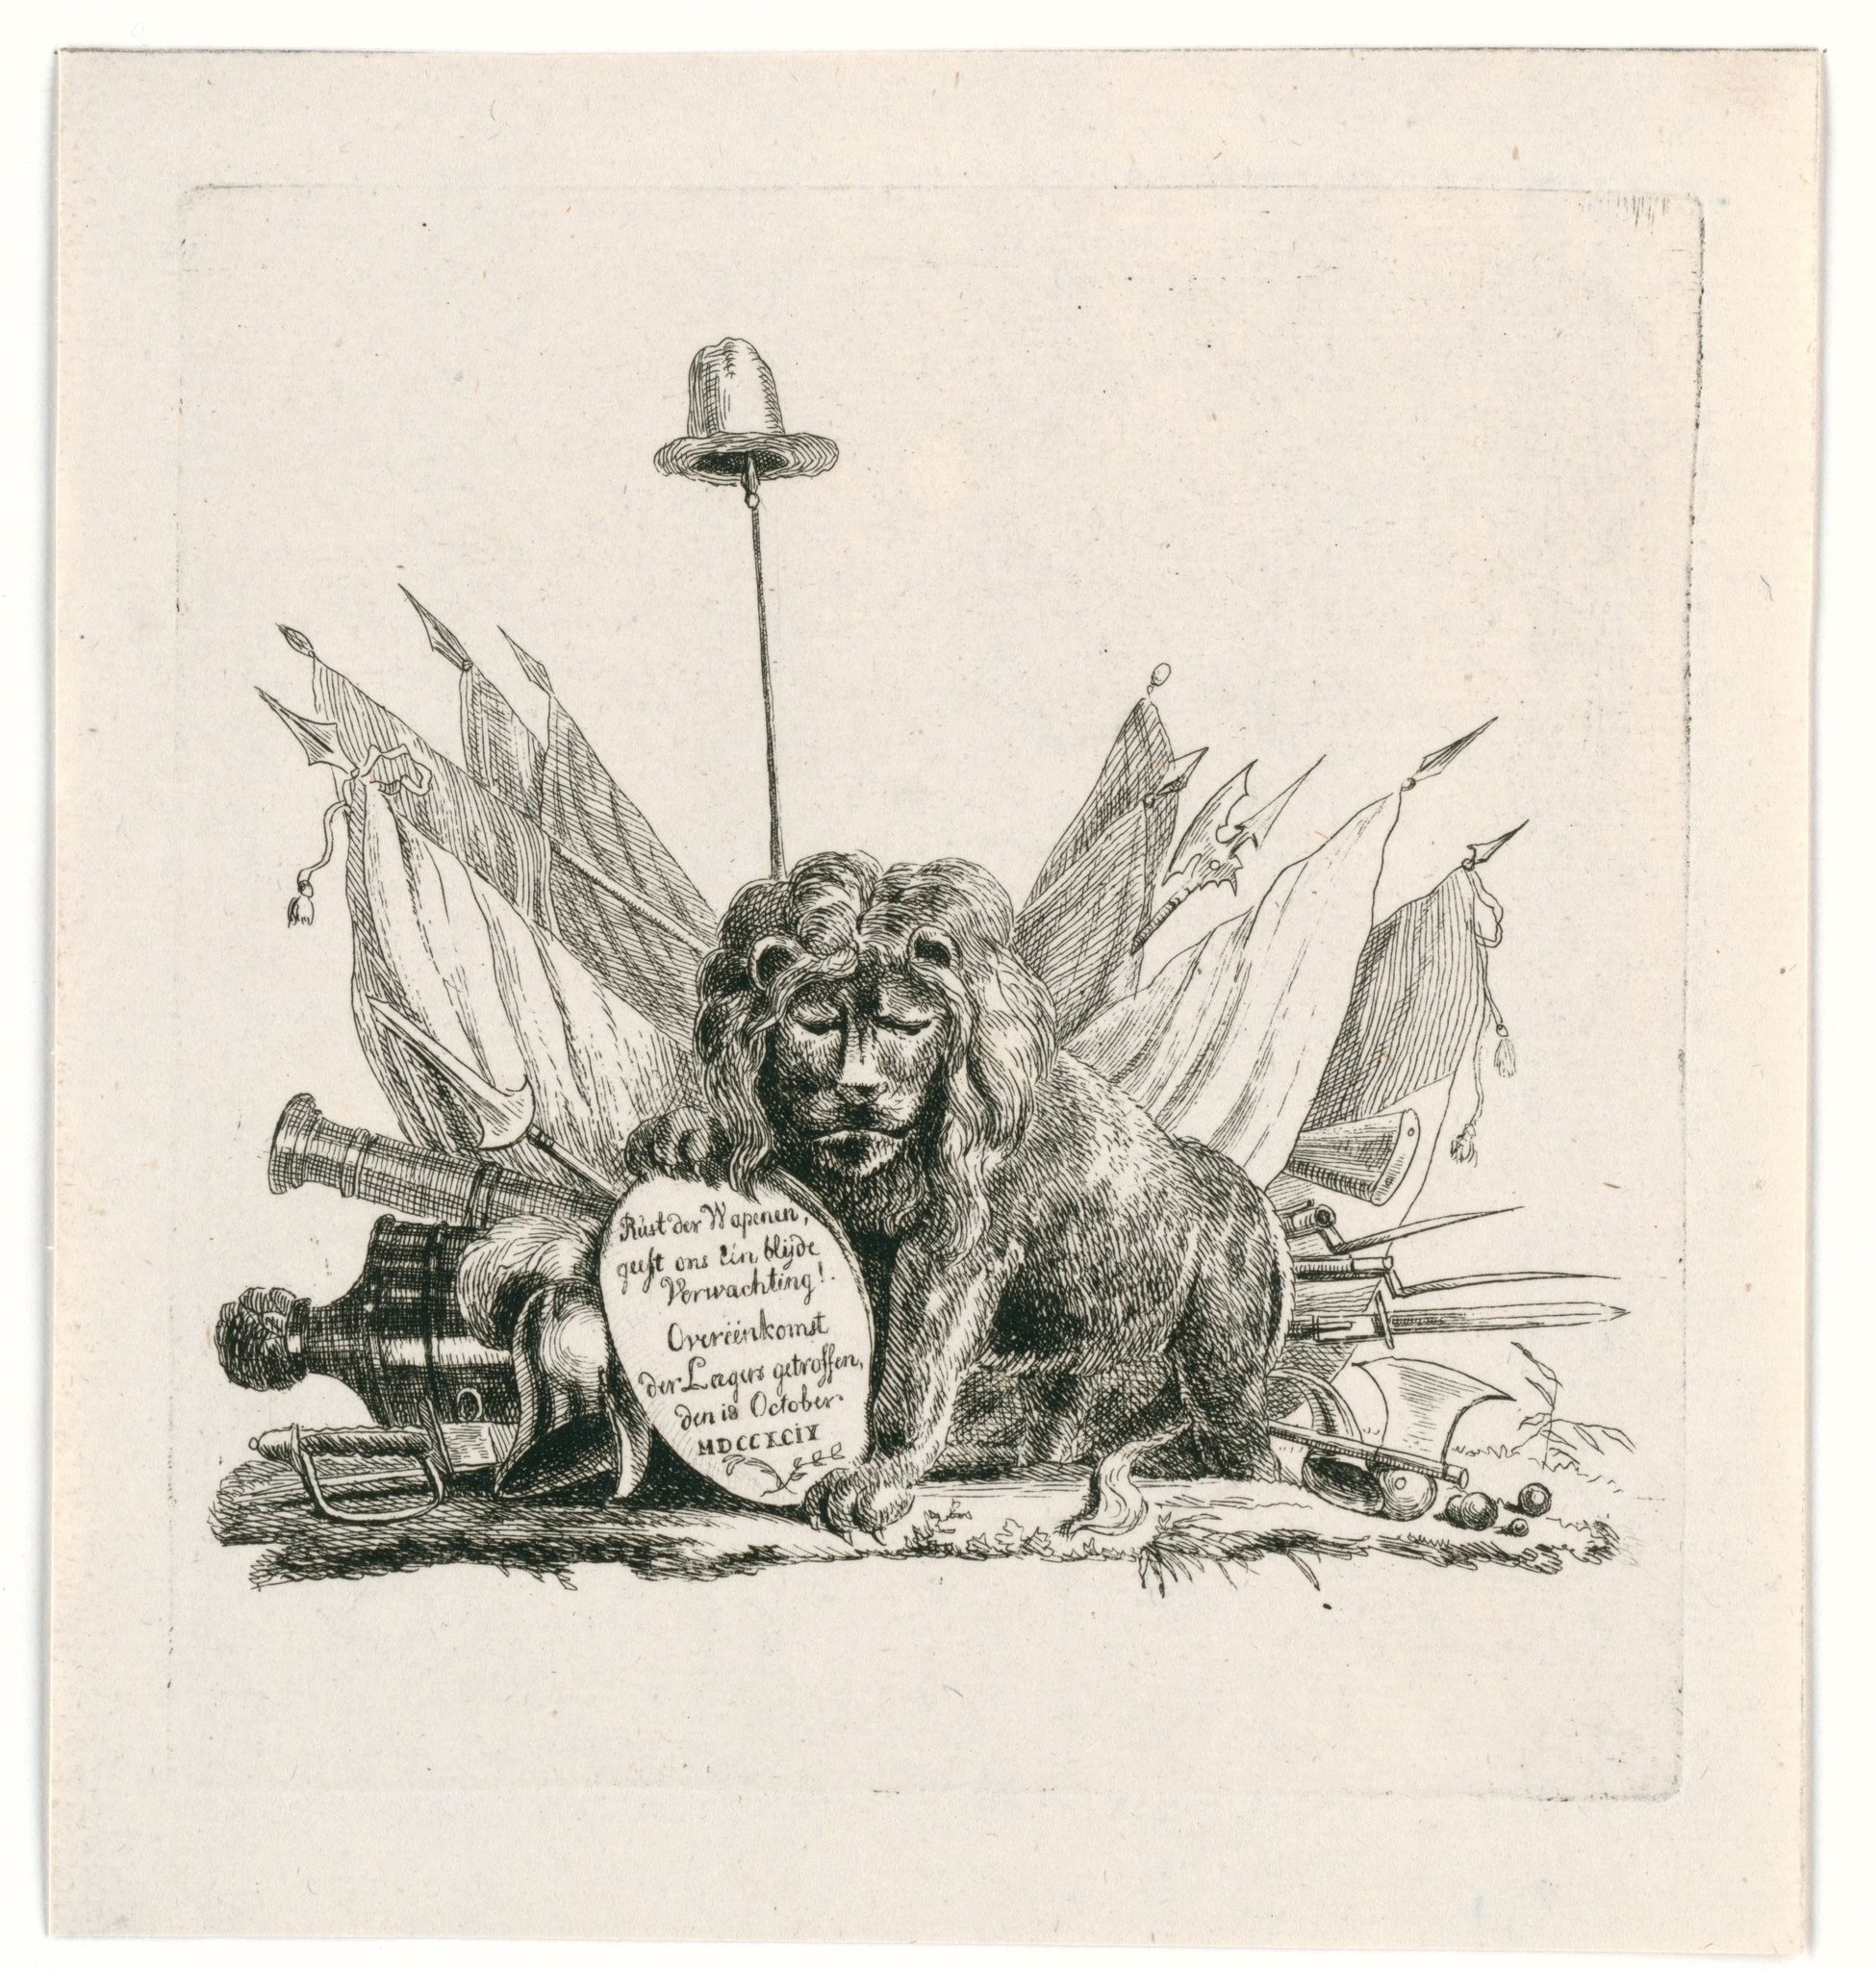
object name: print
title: Allegorie op de wapenstilstand van 18 oktober 1794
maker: pieter gerardus van os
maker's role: draughtsman, painter, print maker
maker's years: 1776-1839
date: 1794-1796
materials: paper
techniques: etching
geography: netherlands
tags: peace negotiations, patriots (1780-1795)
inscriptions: collector's mark: Lugt 2228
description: De Hollandse leeuw toont een schild met het datum van de wapenstilstand. Achter hem vaandels en oorlogsgereedschap en een hoed op een staf.